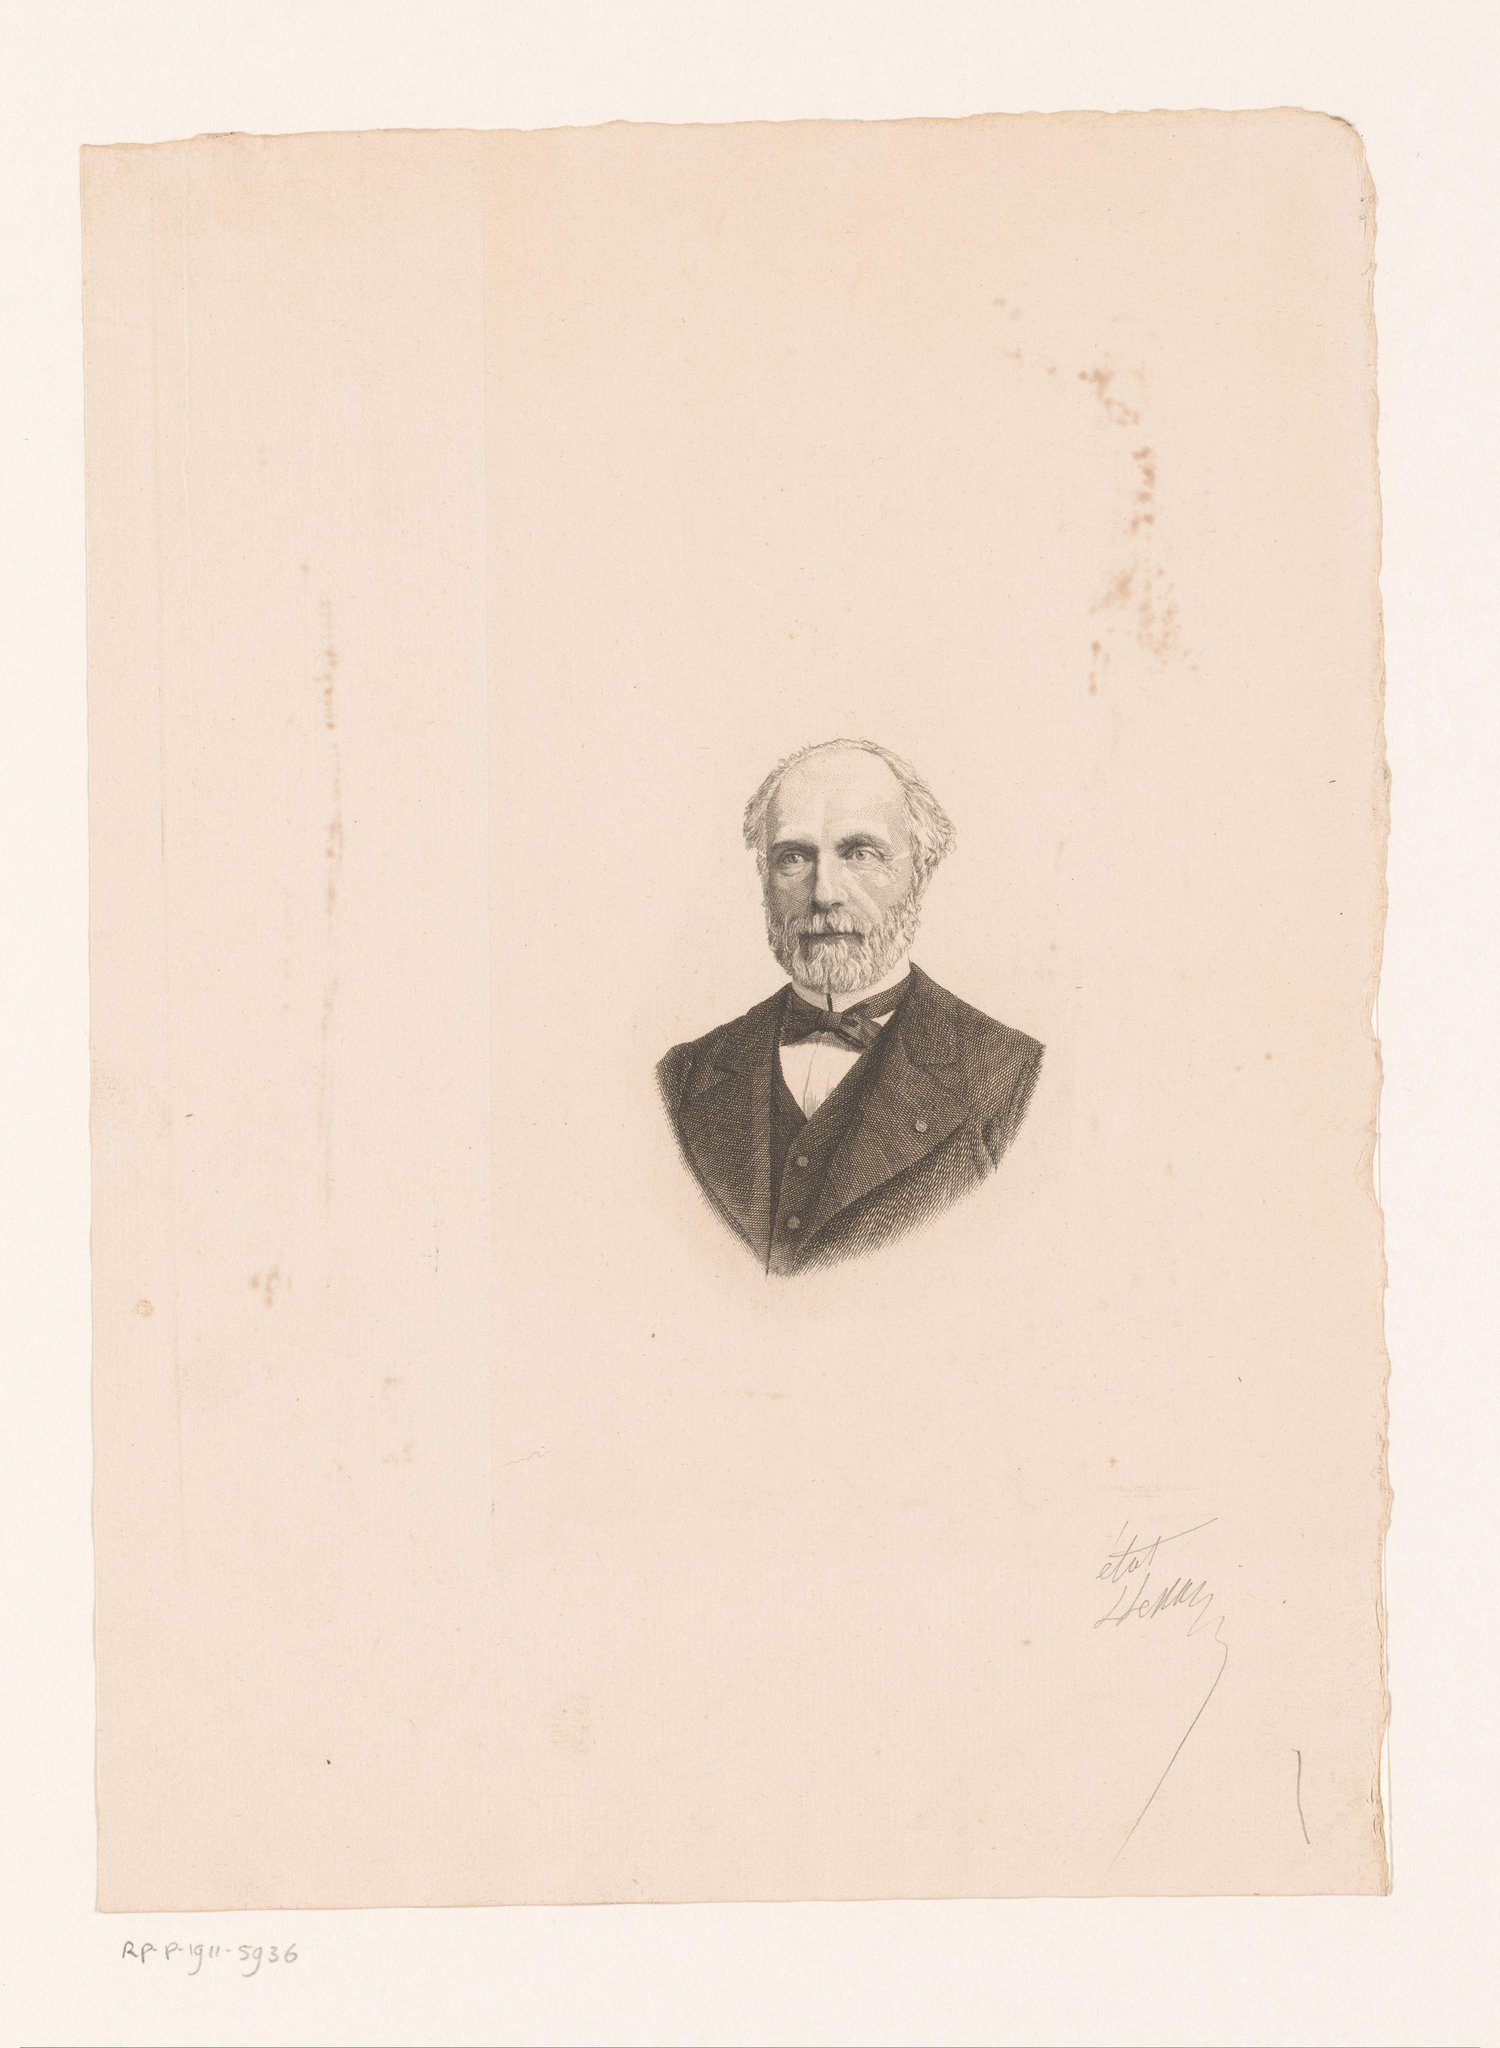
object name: print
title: Portret van Charles de Freycinet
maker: louis le nain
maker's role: print maker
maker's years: 1851-1939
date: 1861-1911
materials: paper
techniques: etching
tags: adult man, historical persons, beard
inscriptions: collector's mark: Lugt 2228, inscription: ‘État LLe Nain’